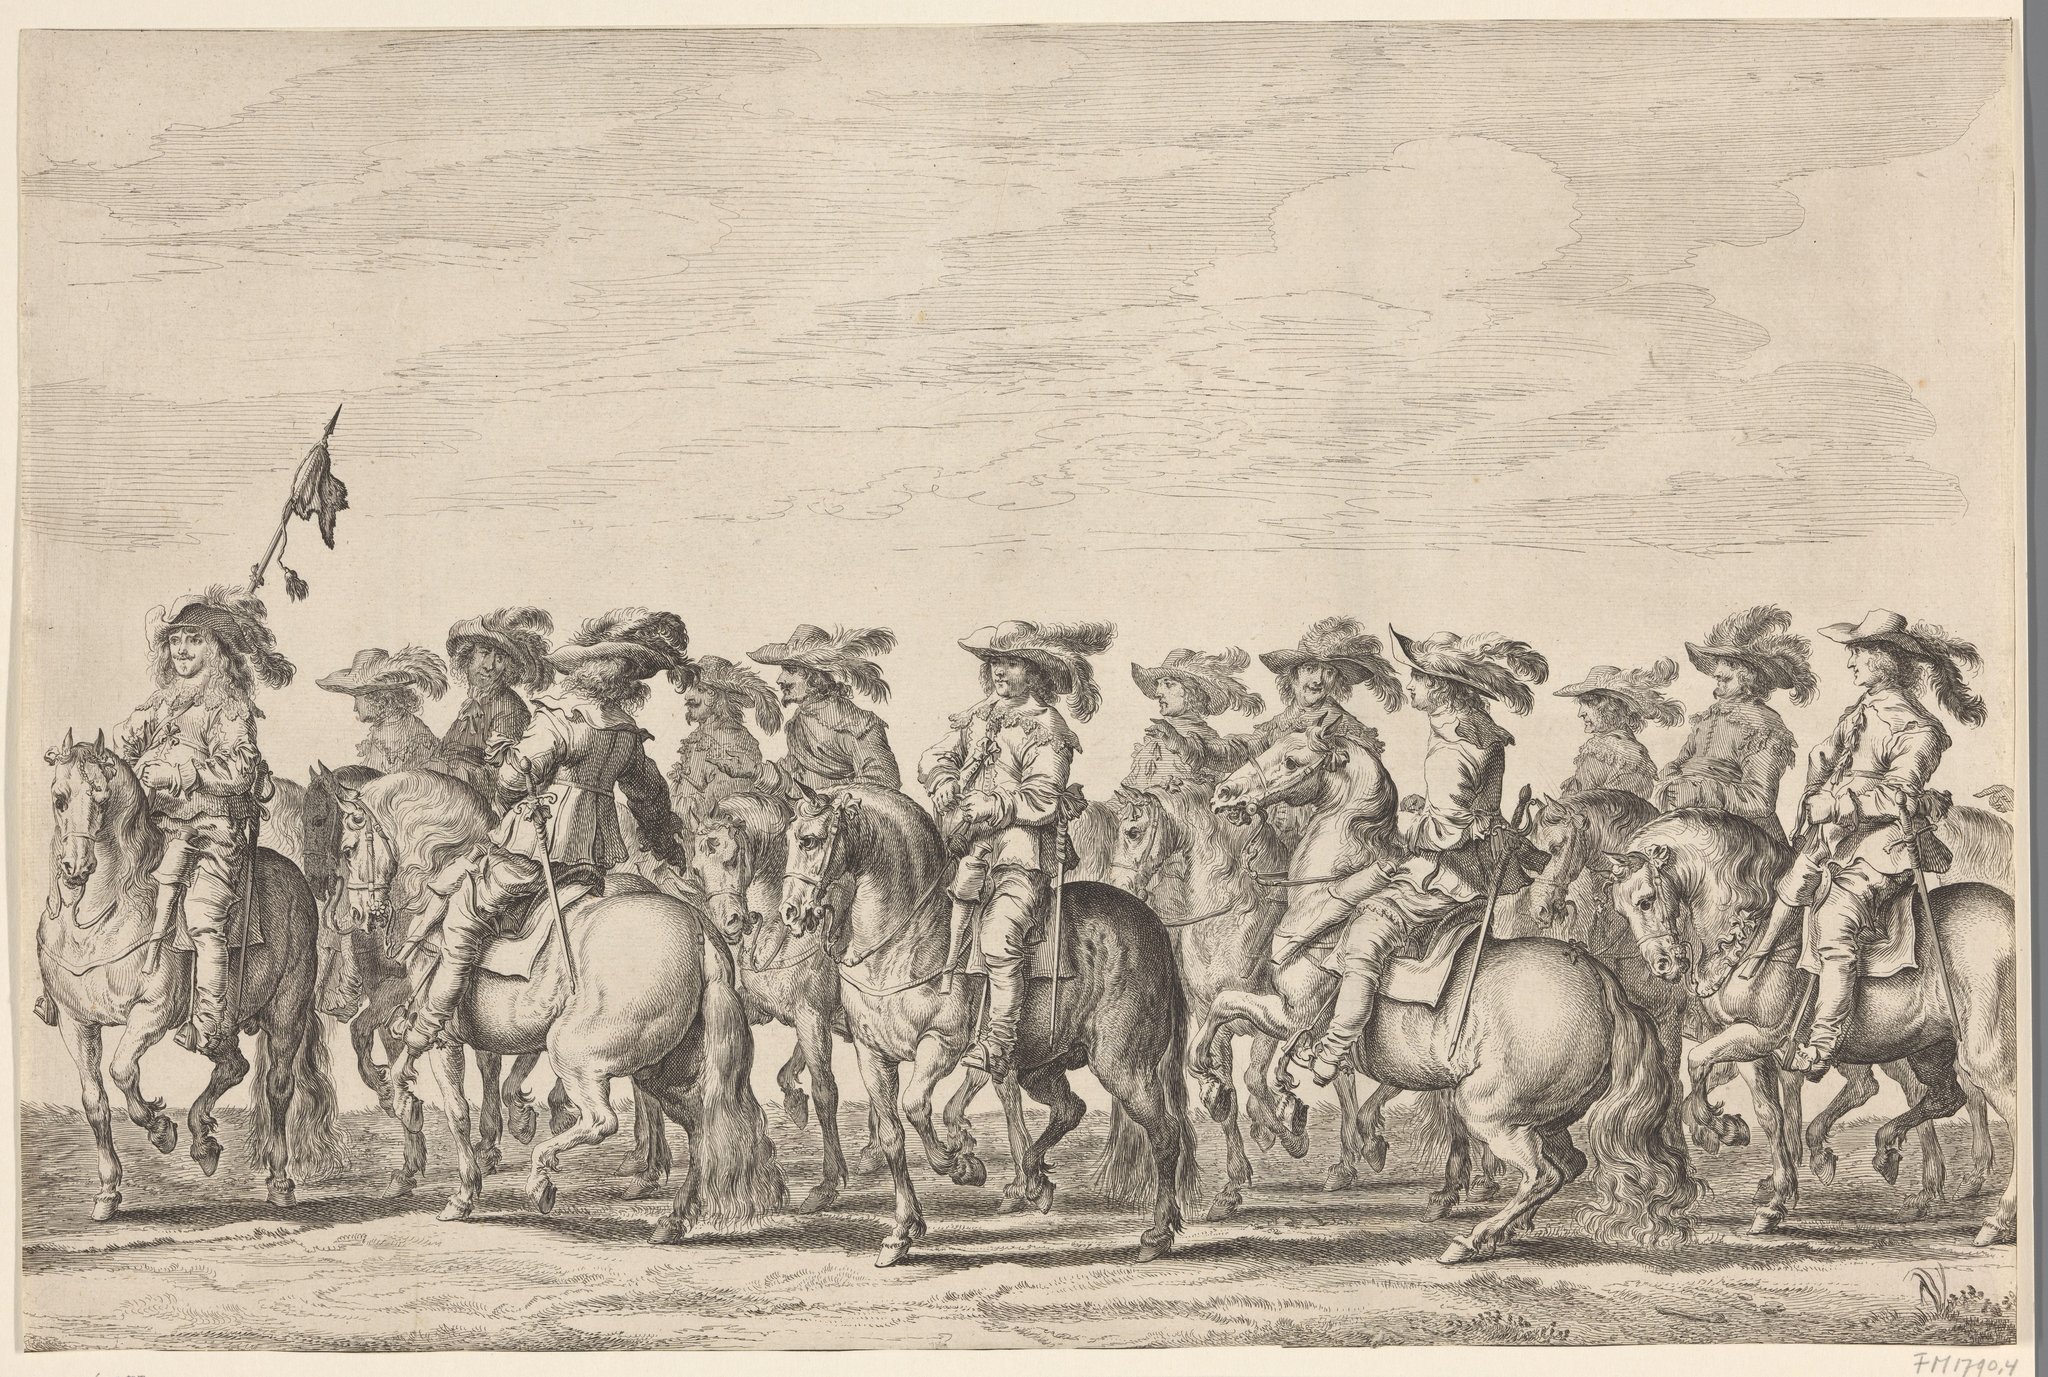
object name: print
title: Intocht van Maria de Médicis te Amsterdam (plaat 4), 1638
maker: pieter nolpe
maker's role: draughtsman, print maker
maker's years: 1613-1653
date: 1638-1639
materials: paper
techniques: engraving, etching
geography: northern netherlands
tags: cologne, print maker, maria de' medici, triumphal entry and public reception, pageant, 'entrée solennelle', 'joyeuse entrée', amsterdam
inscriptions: collector's mark: Lugt 240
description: Intocht van de Franse koningin Maria de Médicis te Amsterdam, 31 augustus 1638. Vierde plaat in een ongemonteerd ensemble bestaande uit een titelblad, een portret en zeven bladen van de stoet. Een deel van de stoet met ruiters met een voorrijder met een klein vaandel.